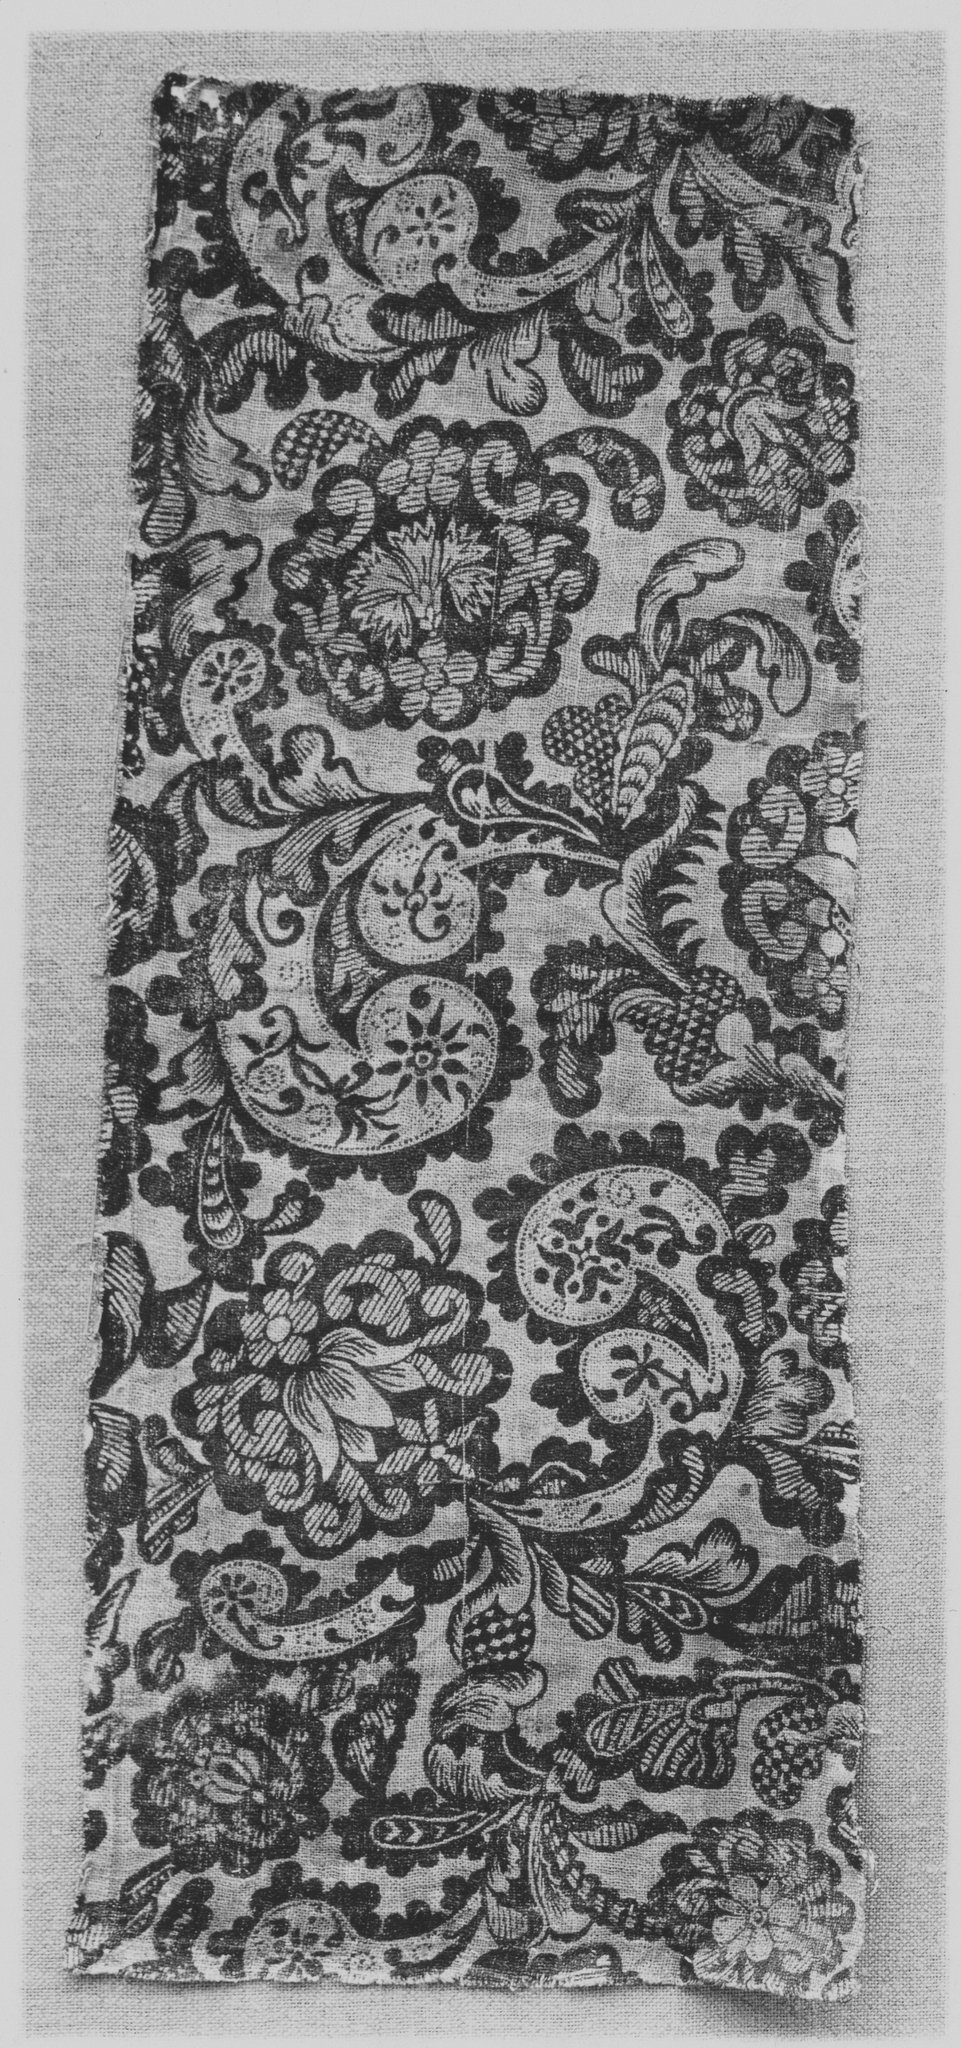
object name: fragment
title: Fragment of printed linen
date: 1700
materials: linen